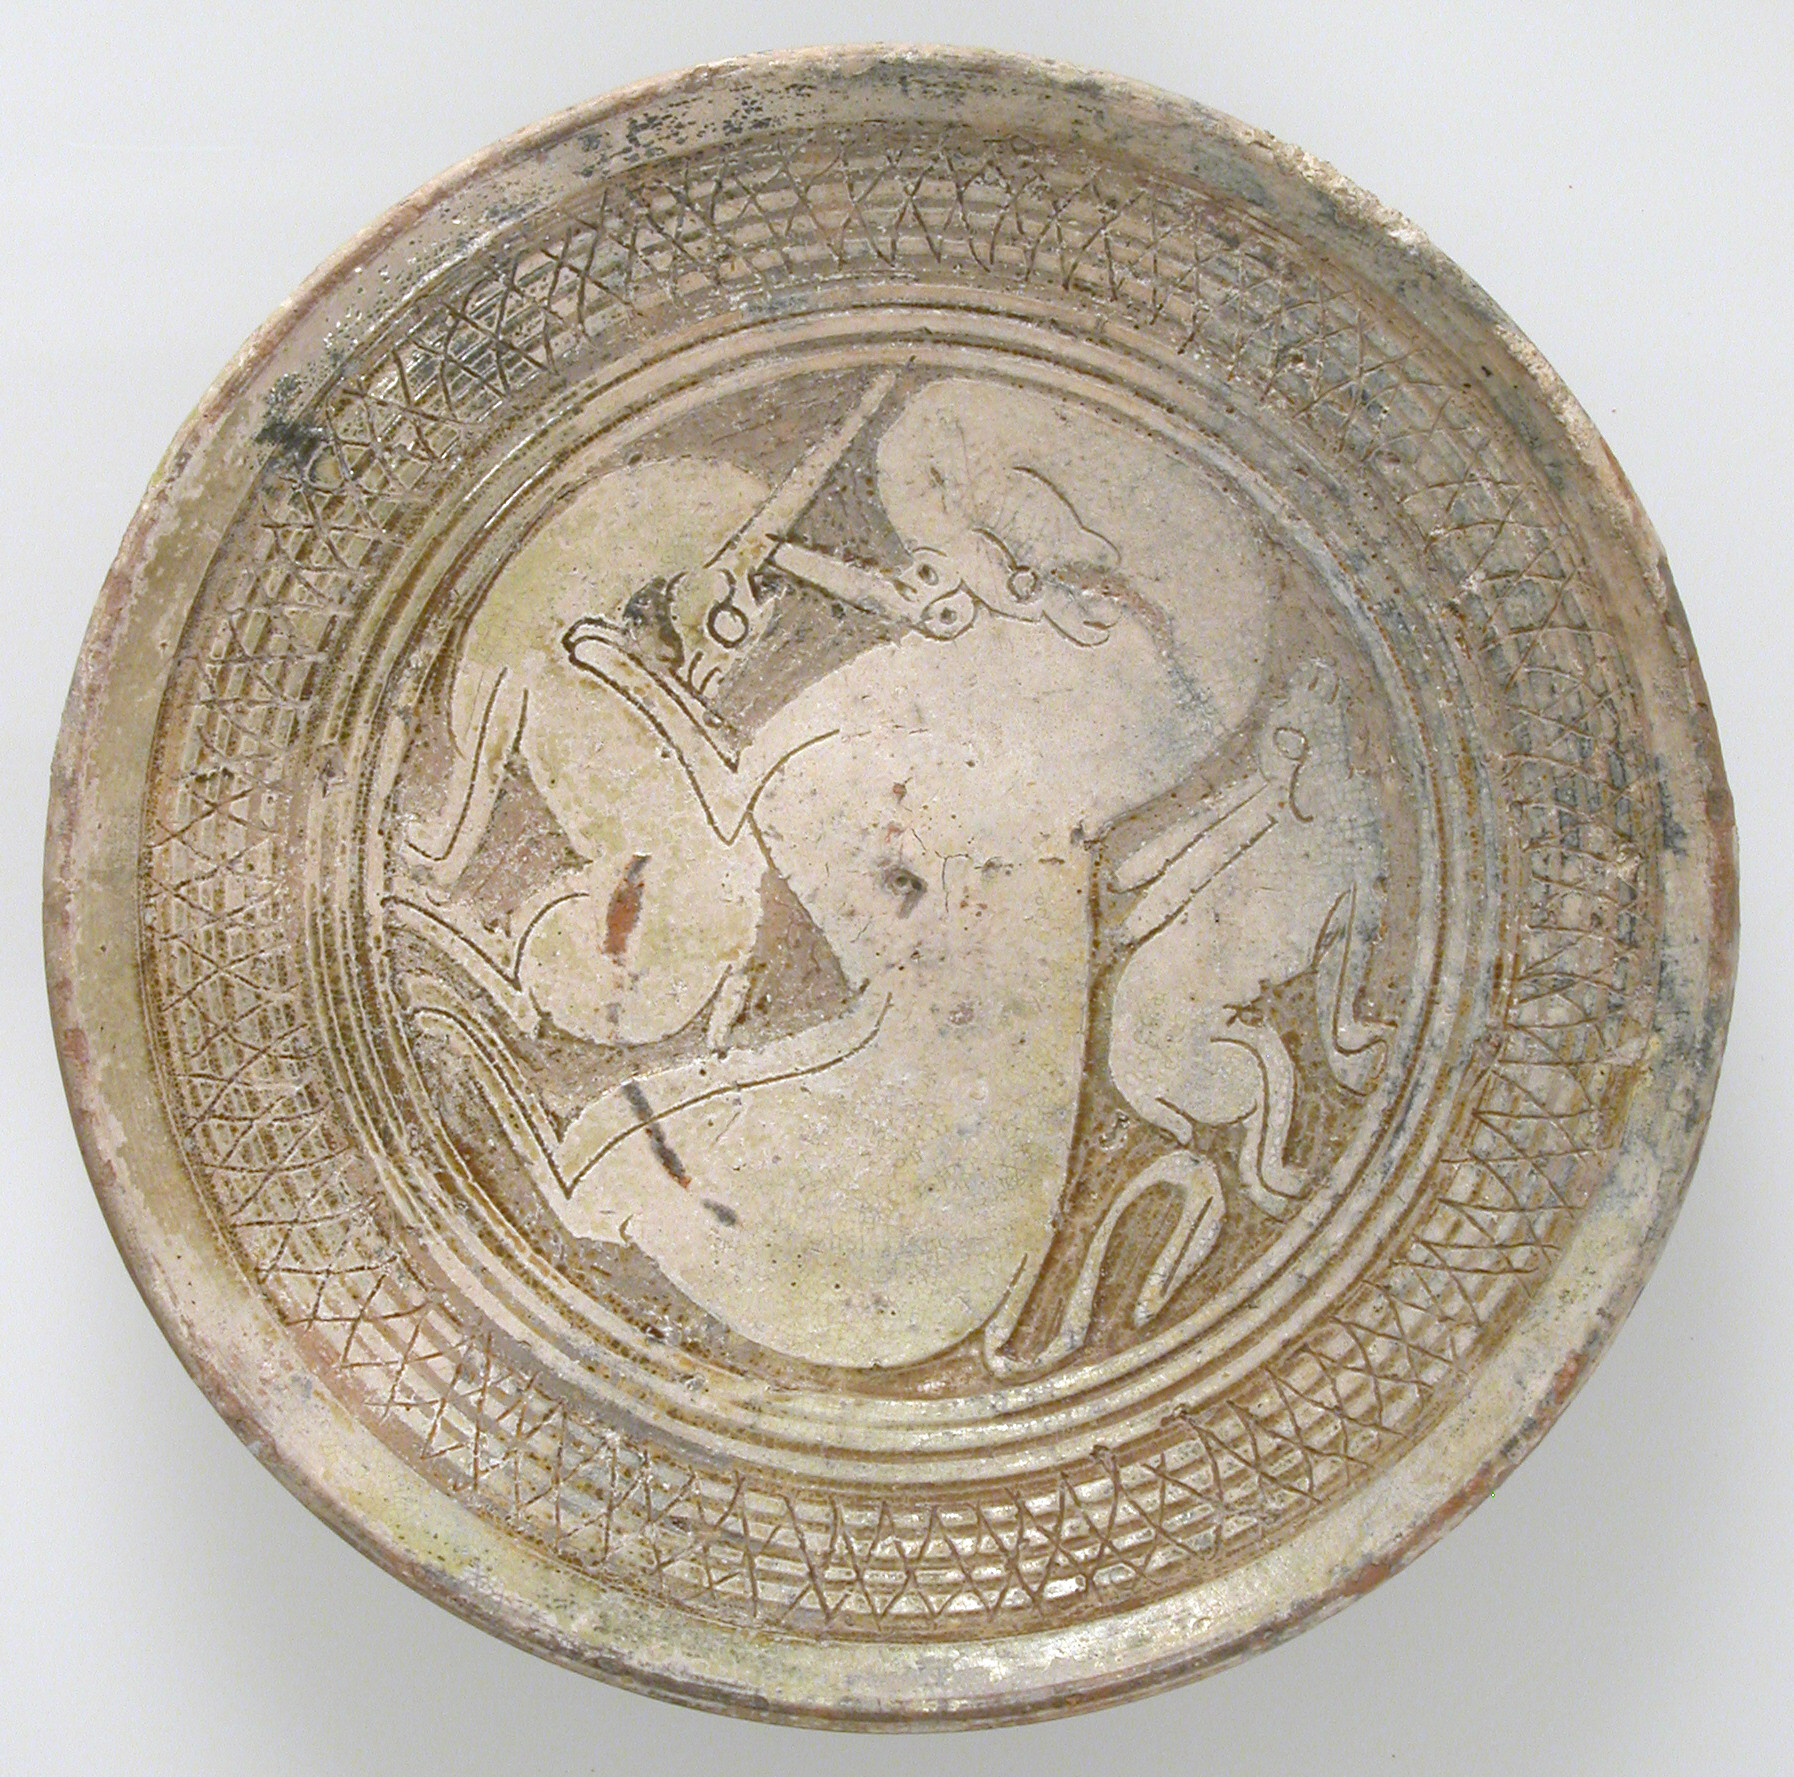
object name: bowl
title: Bowl with Three Animals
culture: byzantine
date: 1100-1300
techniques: cutting, engraving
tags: animals